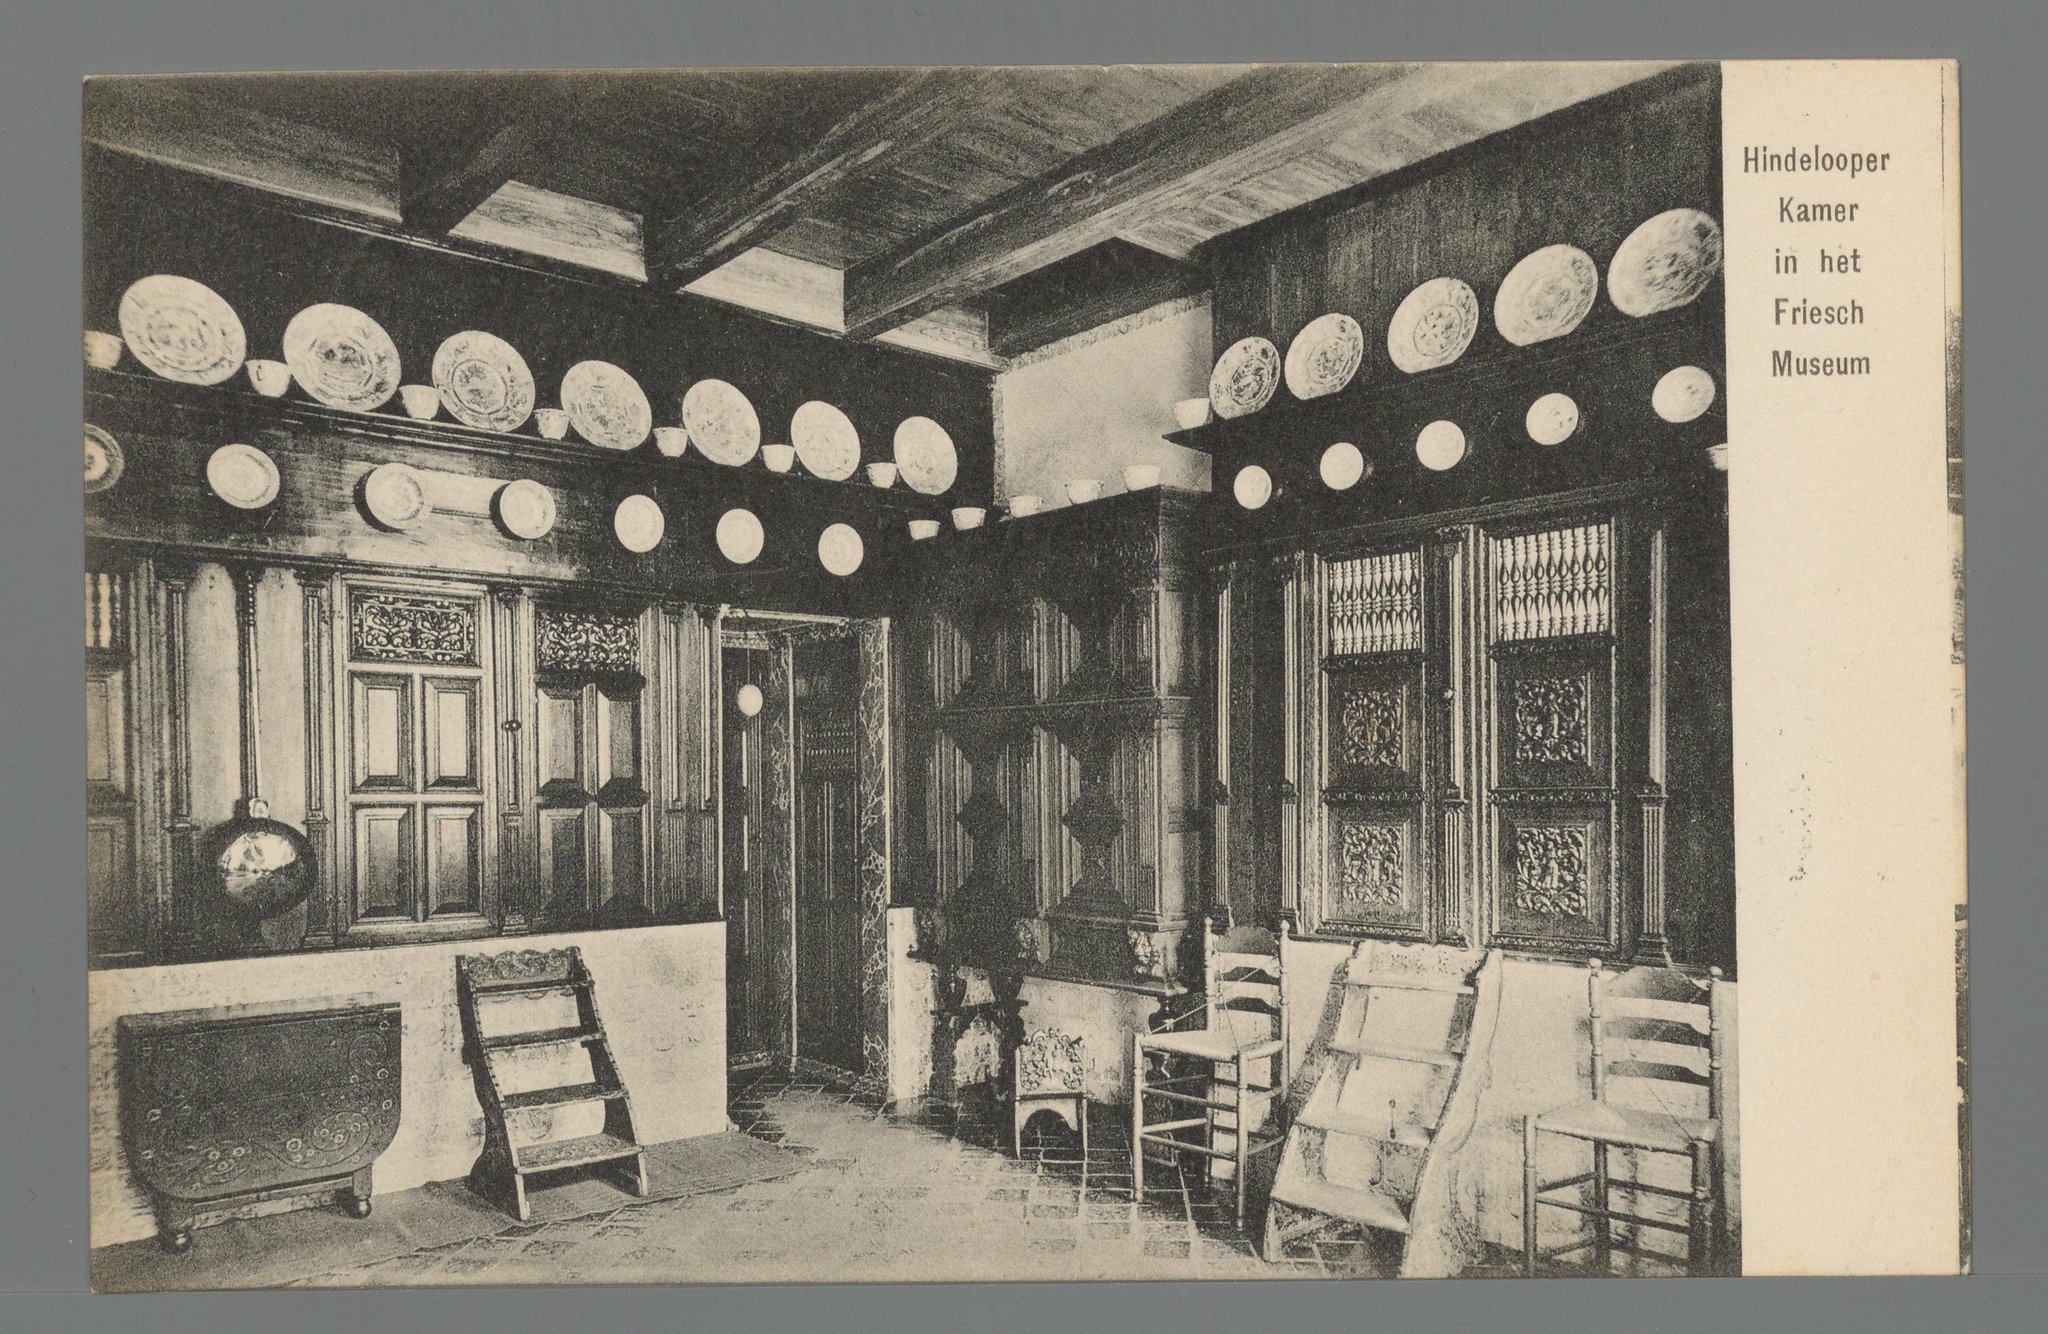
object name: photomechanical print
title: Hindelooper Kamer in het Friesch Museum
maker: Anonymous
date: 1905-1911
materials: cardboard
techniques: photograph, writing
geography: leeuwarden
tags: interior of the house, permanent exhibition, museum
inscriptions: postage stamp